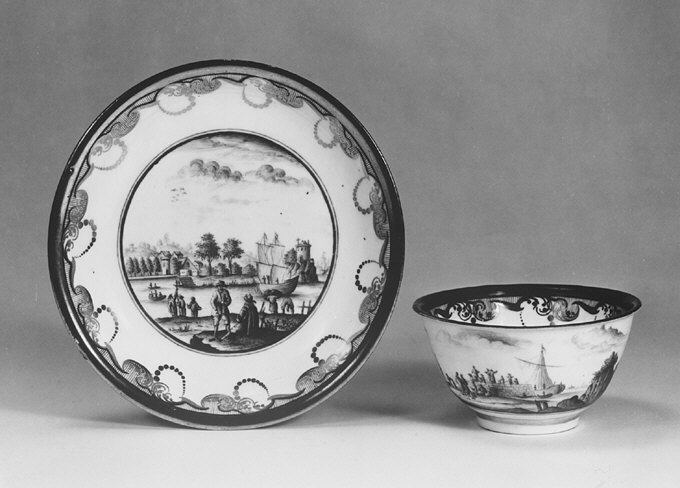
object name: teabowl and saucer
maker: meissen manufactory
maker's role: manufactory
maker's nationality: german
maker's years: 1710-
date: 1744-1748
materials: hard paste porcelain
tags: rivers,boats